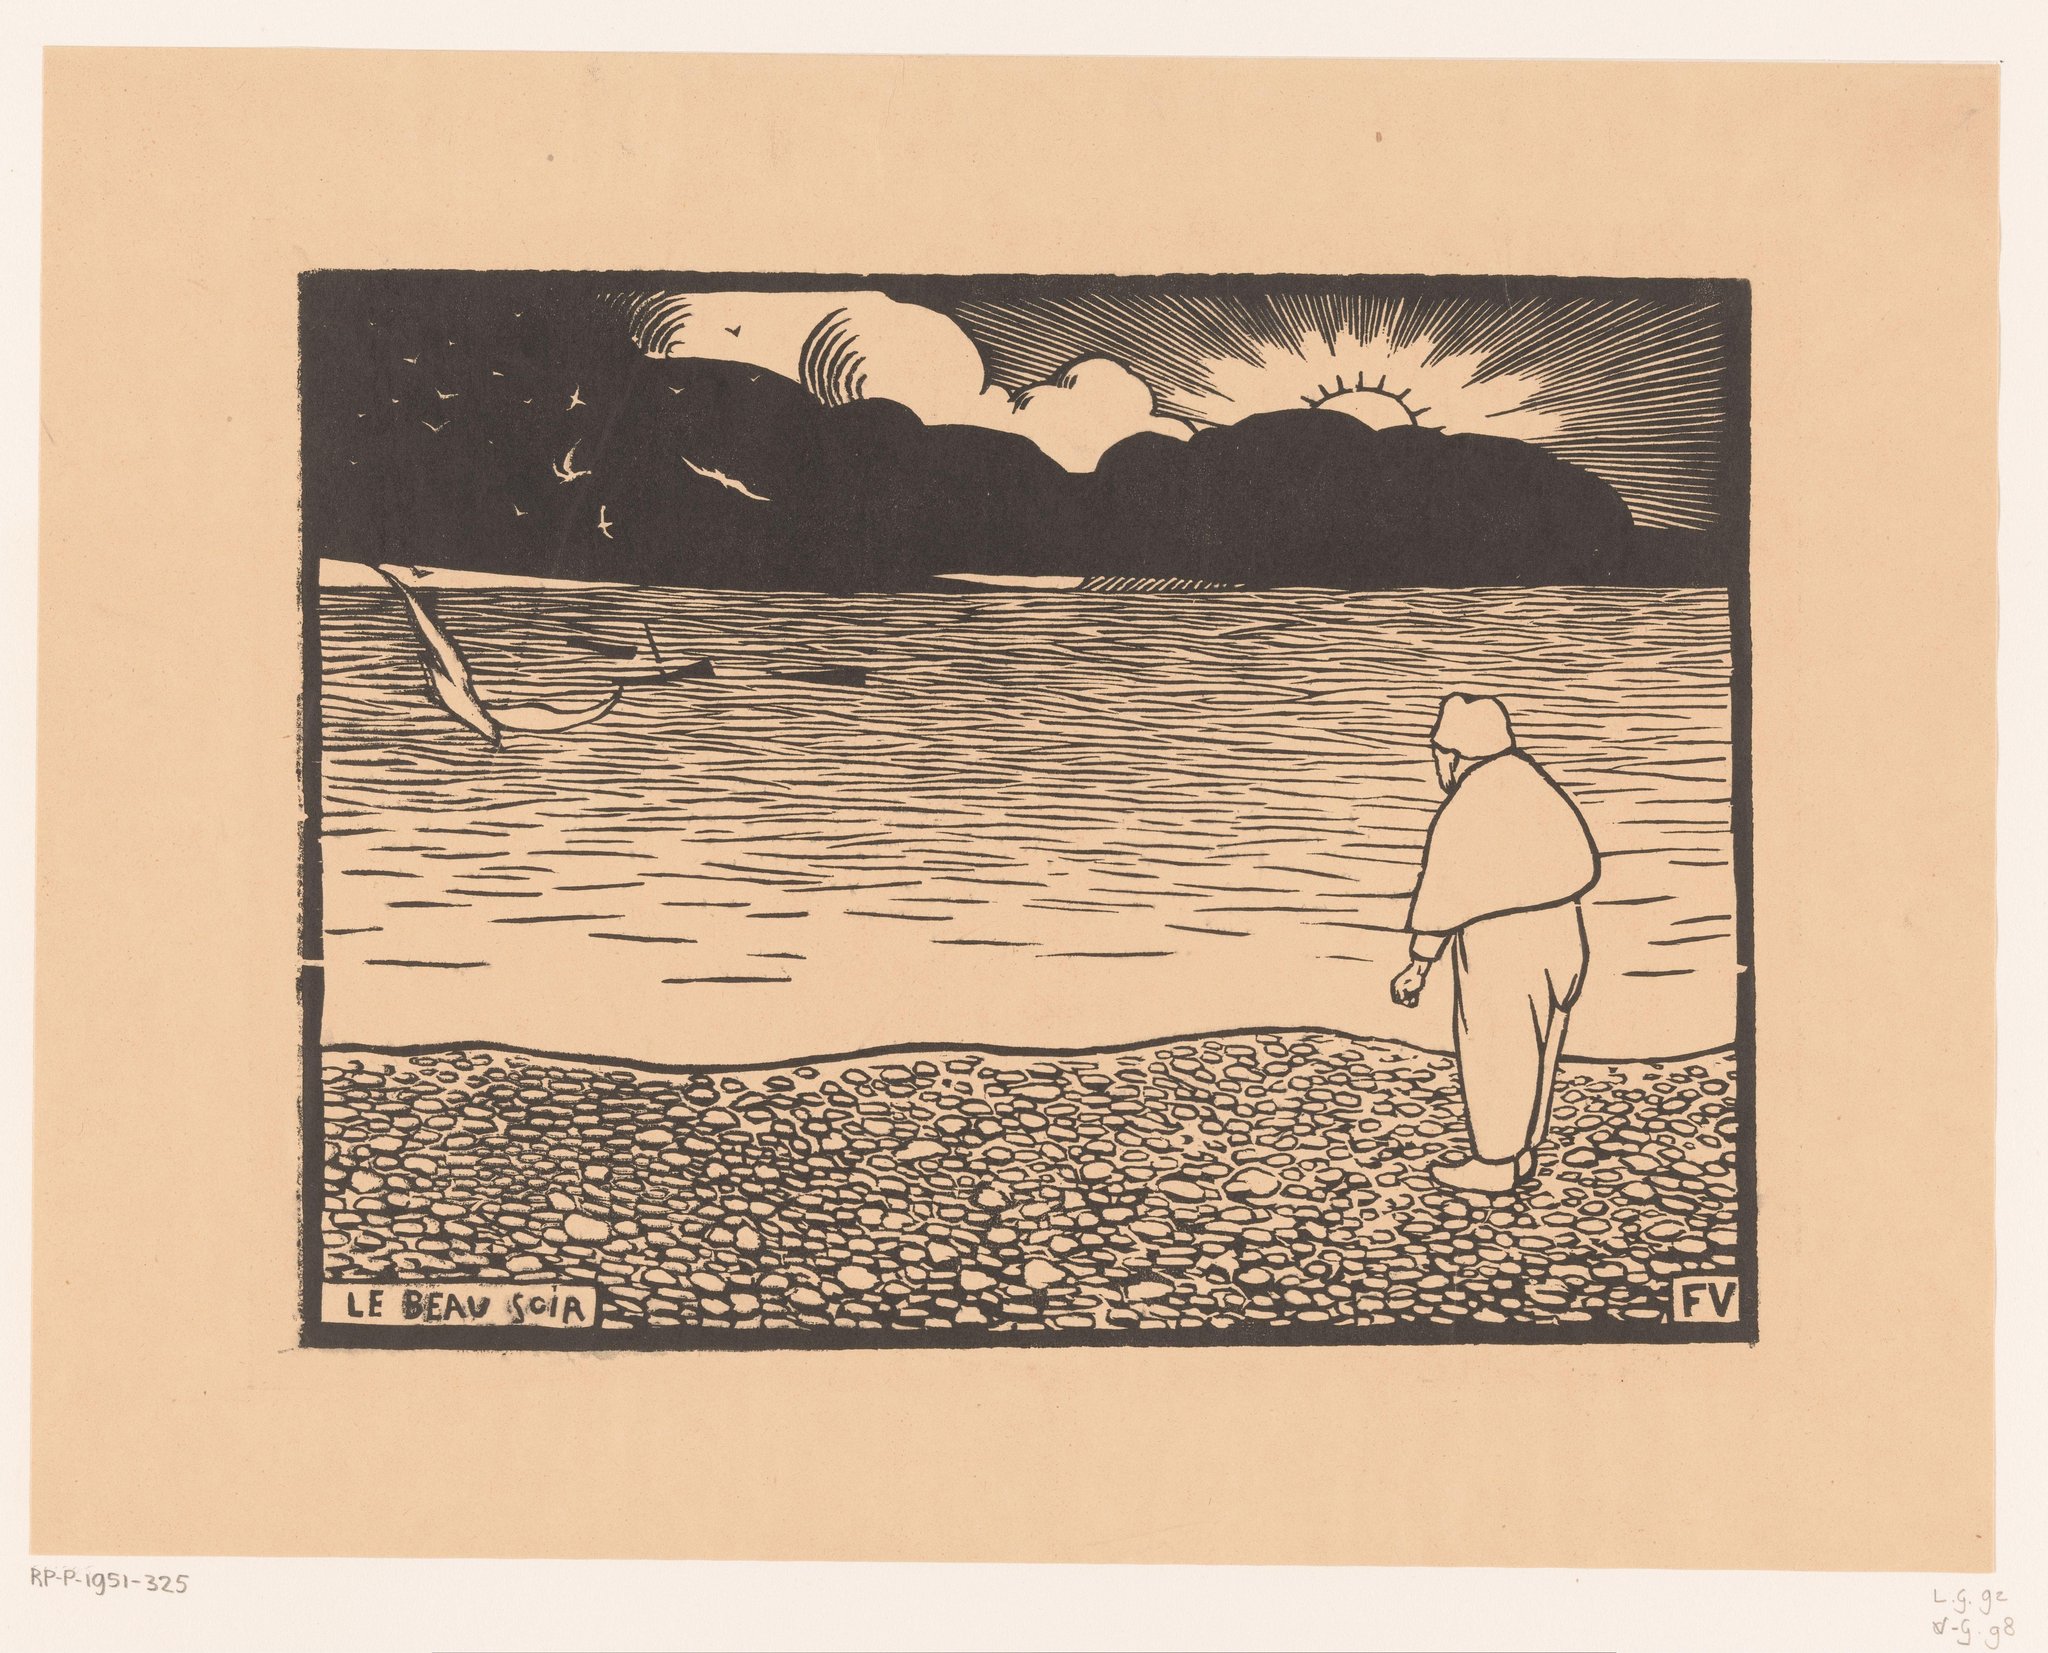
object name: print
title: Le beau-soir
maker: félix edouard vallotton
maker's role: print maker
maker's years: 1865-1925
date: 1892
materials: paper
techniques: woodcut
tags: evening, sea (seascape), sunset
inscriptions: collector's mark: Lugt 2228